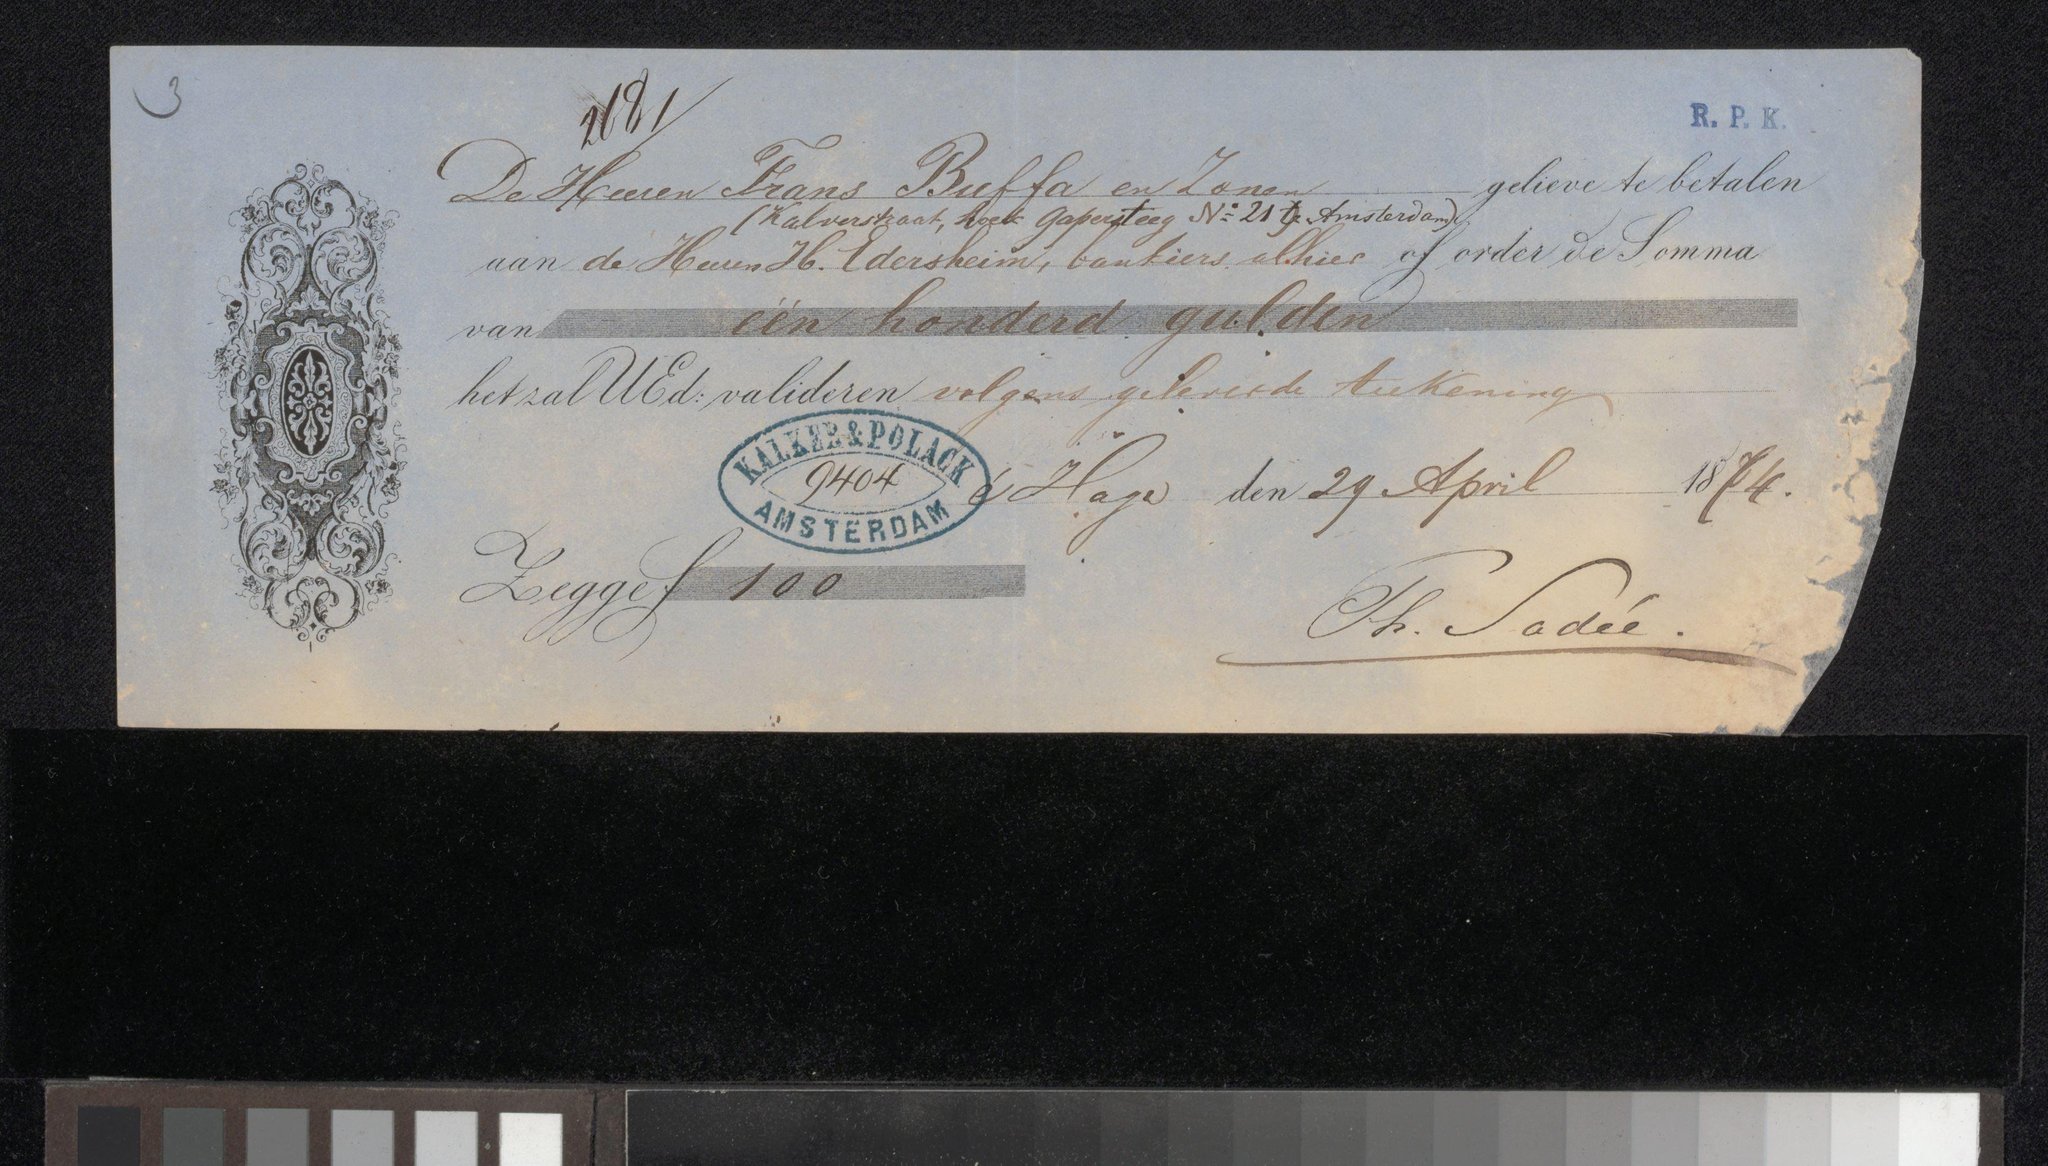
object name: ontvangstbewijs, kwitantie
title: Kwitantie voor Frans Buffa en Zonen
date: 1874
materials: ink, paper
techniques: pen, printing, writing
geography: the hague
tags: publisher, drawing, money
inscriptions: name: ‘KALKER & POLAK AMSTERDAM’, collector's mark: Lugt 2233